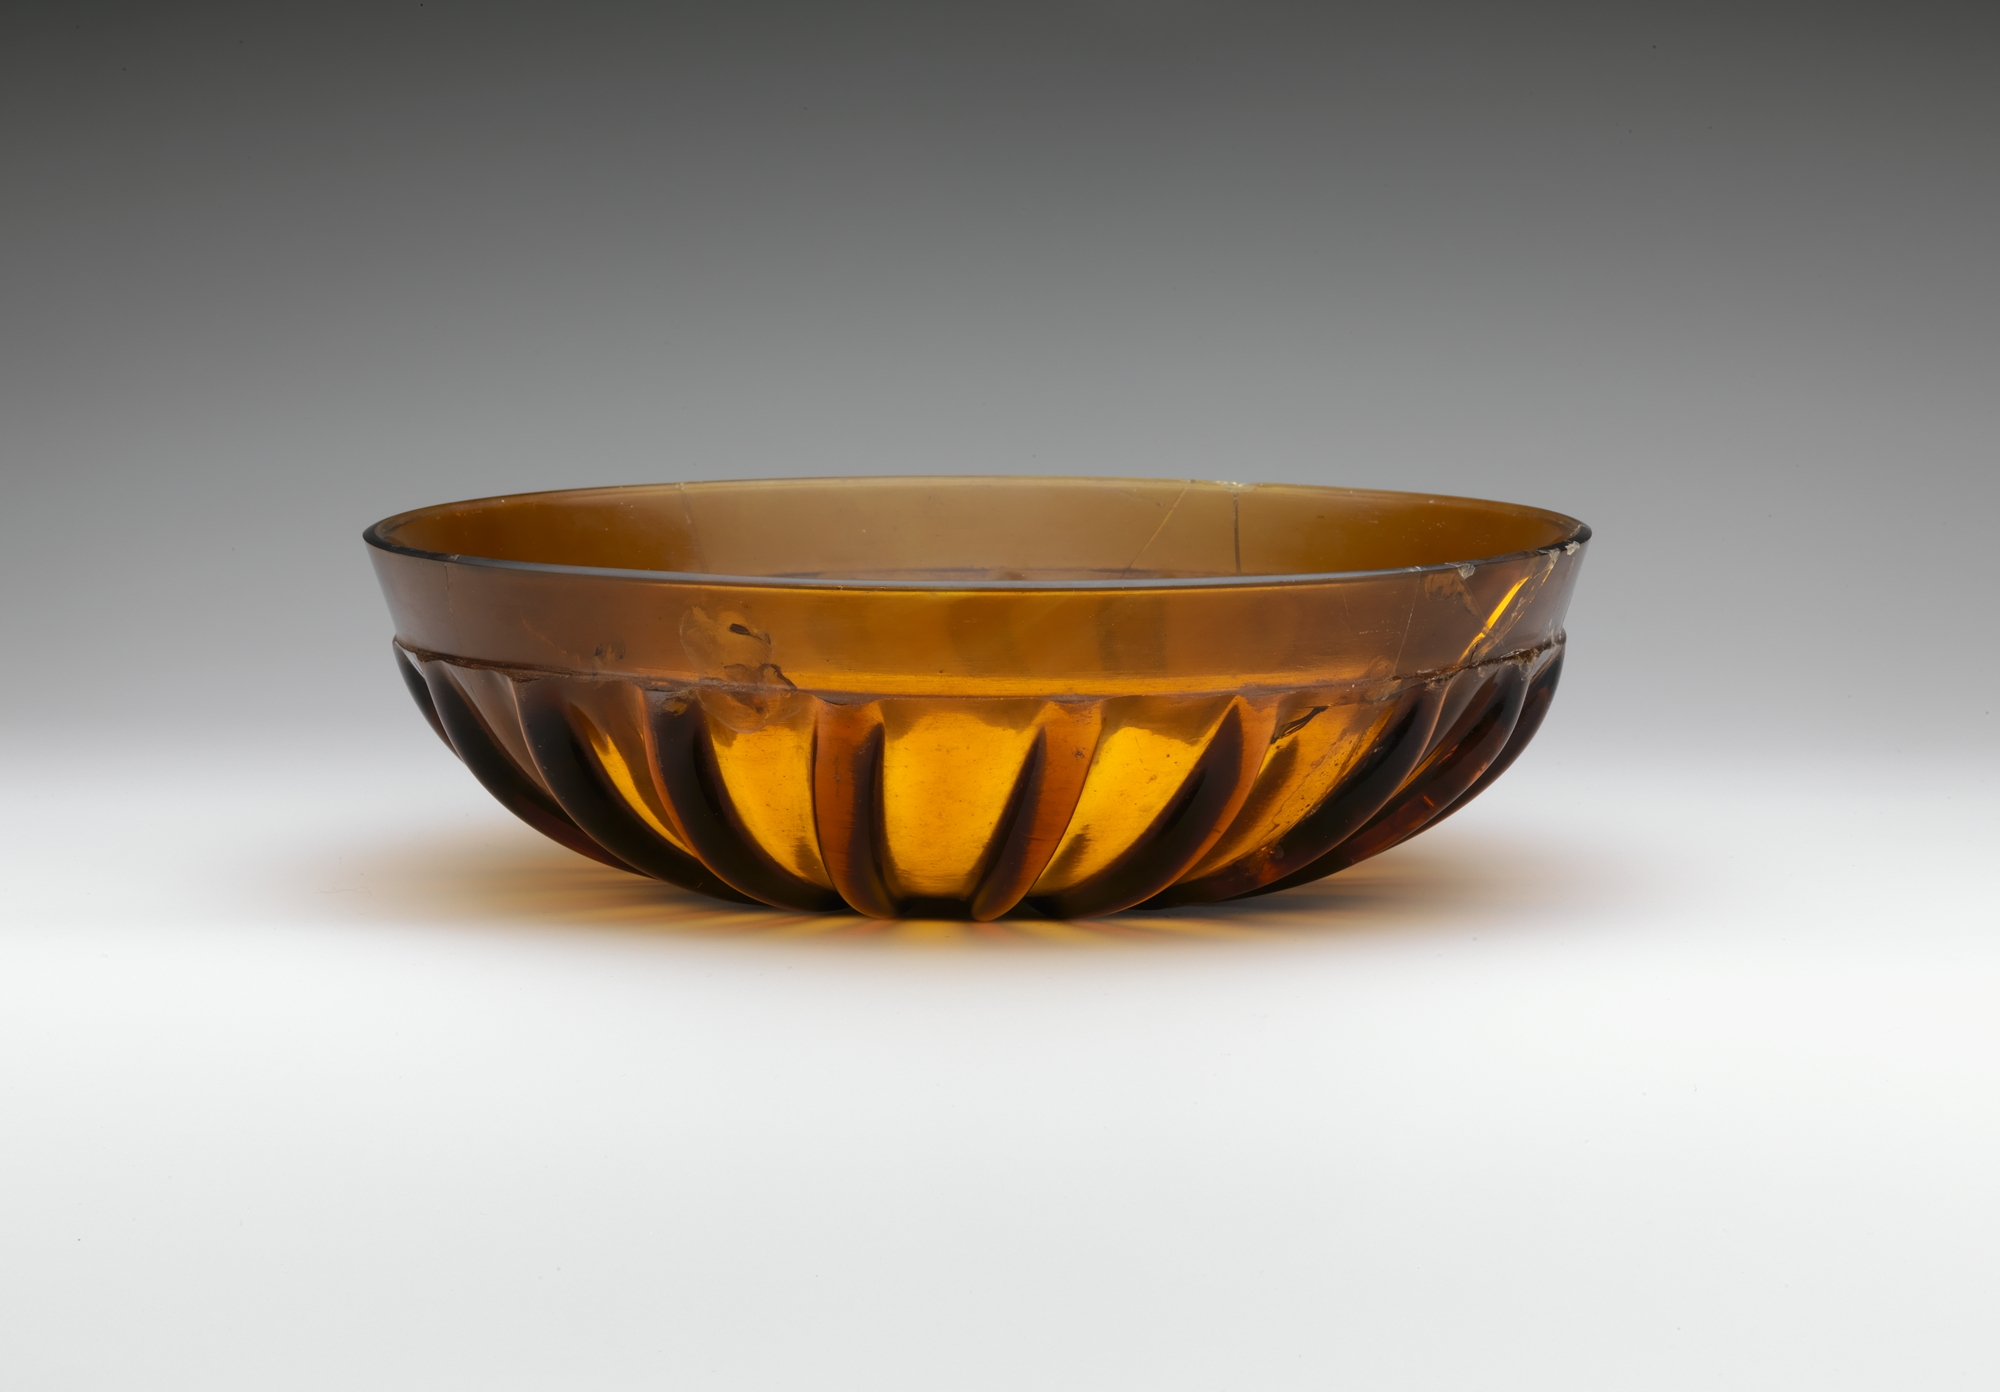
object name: bowl, ribbed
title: Glass ribbed bowl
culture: roman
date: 1-33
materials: glass